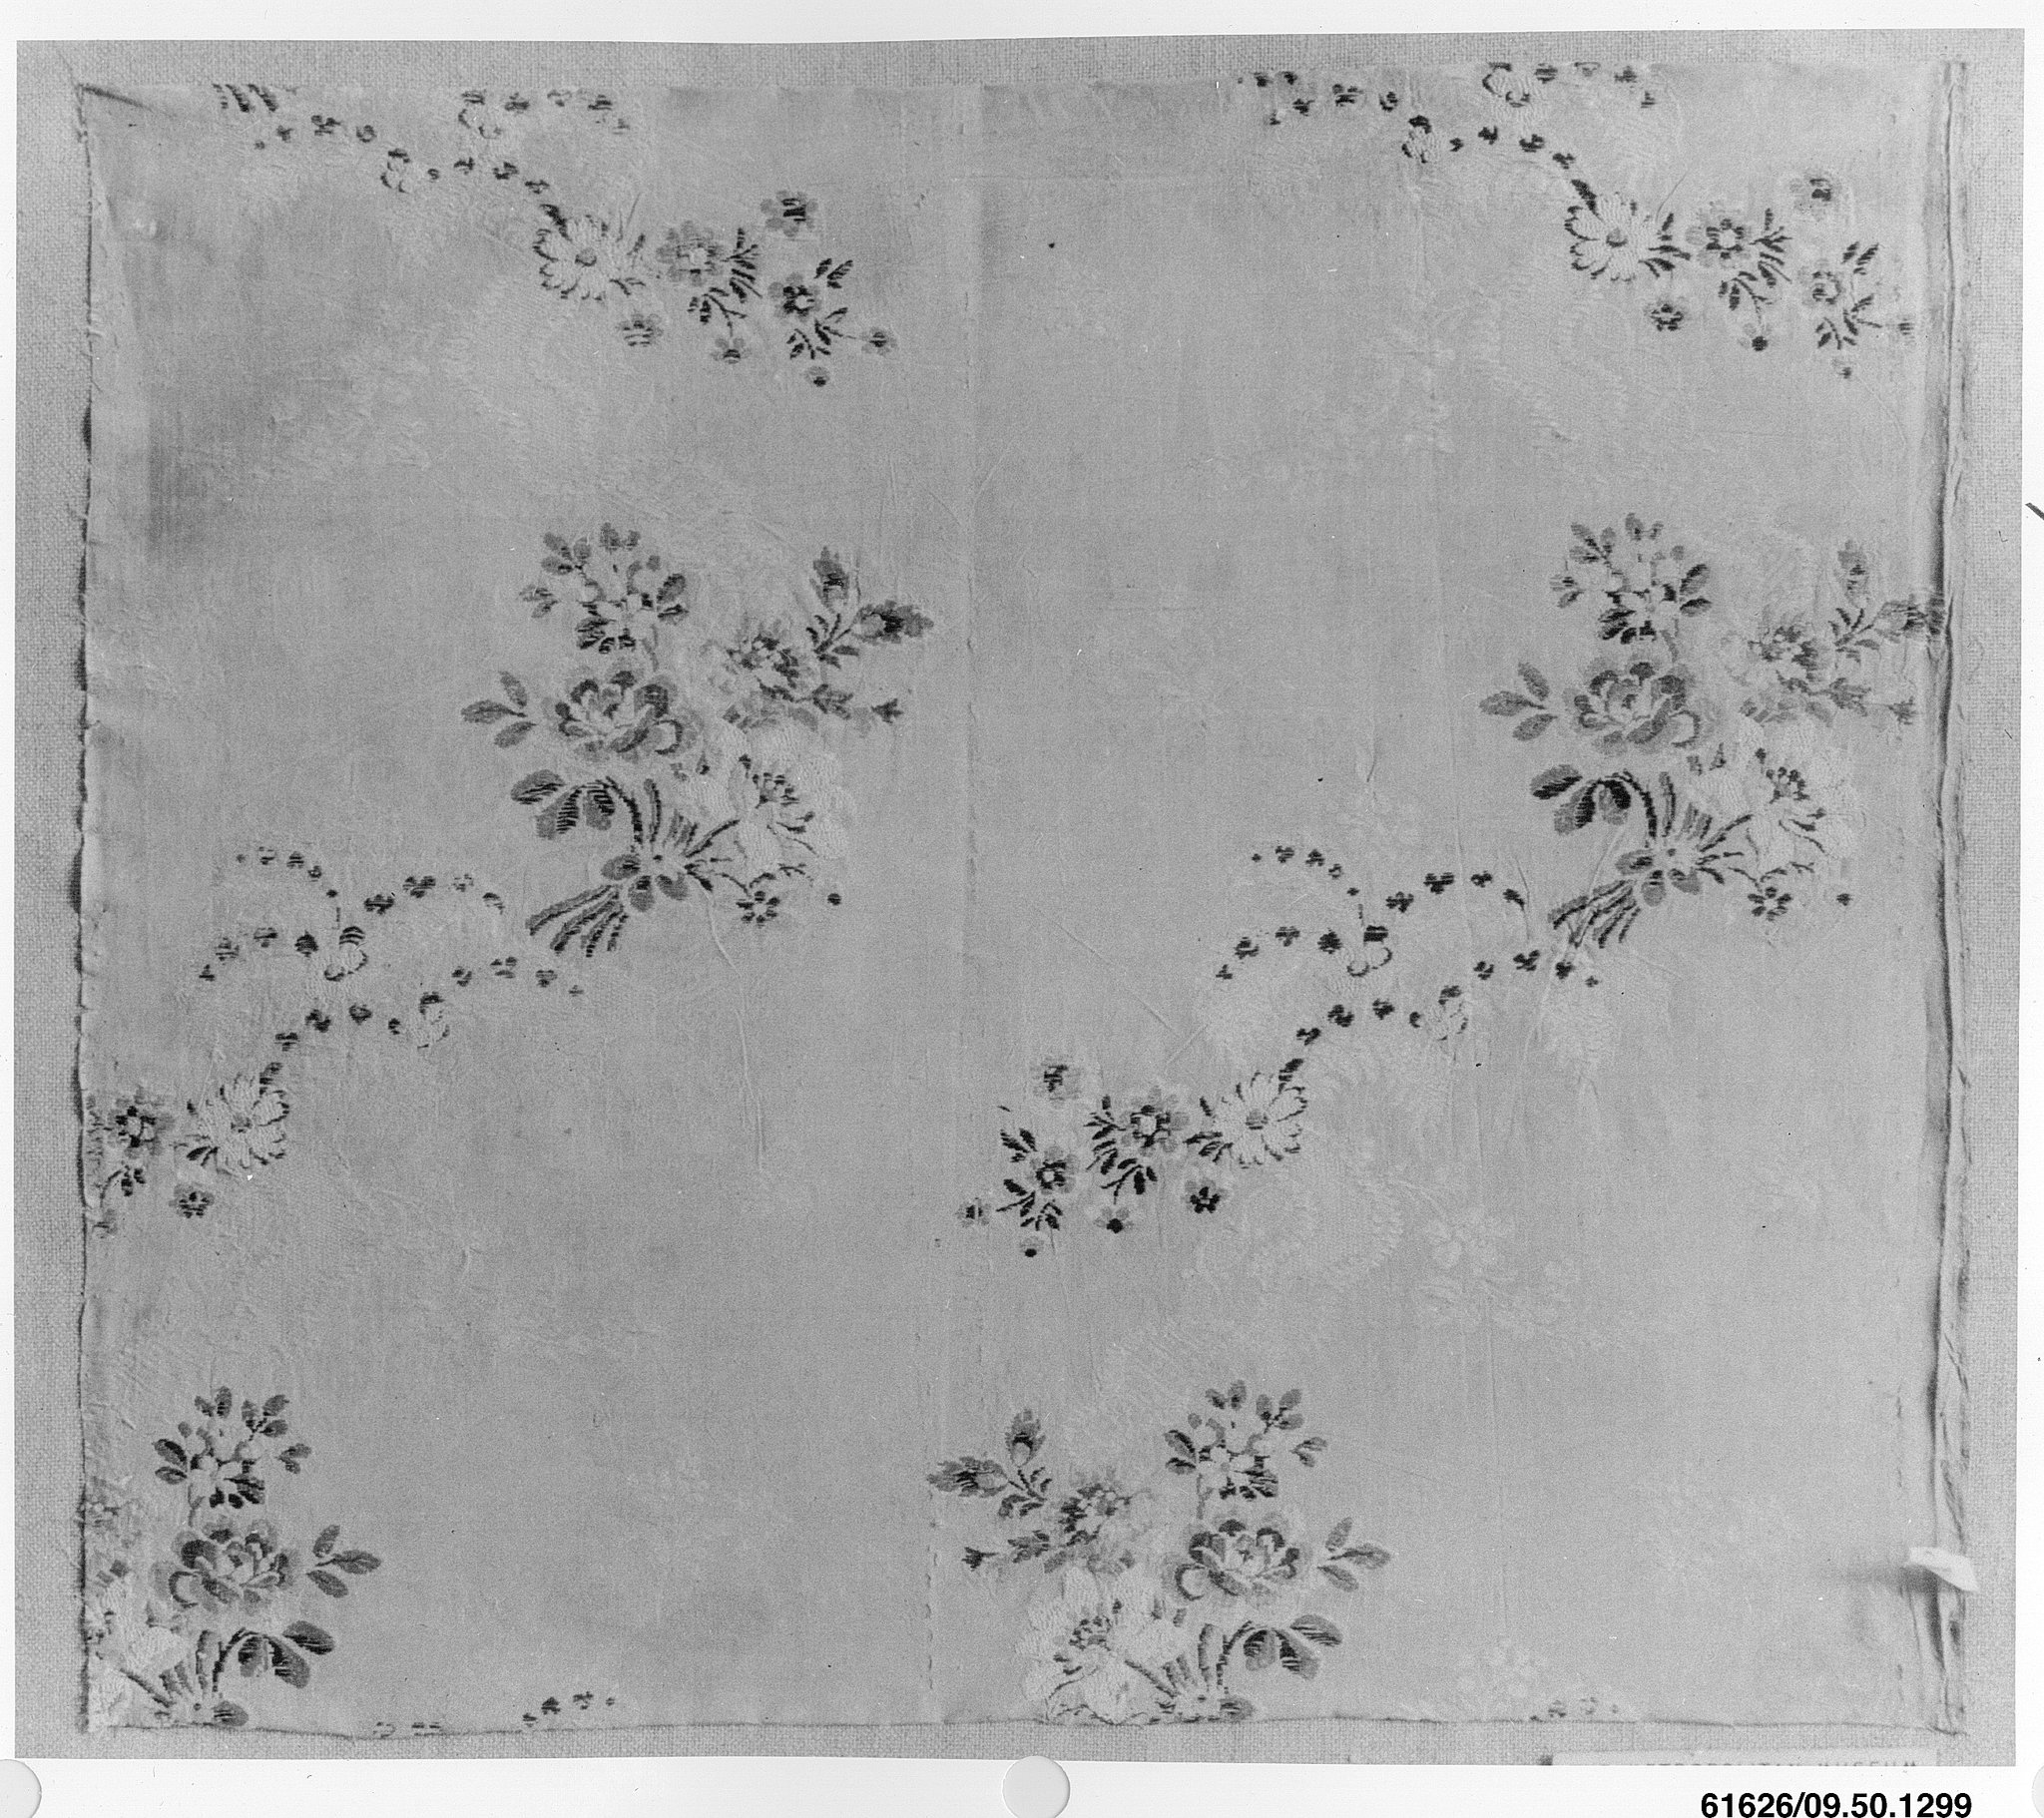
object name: piece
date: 1760-1770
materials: silk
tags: flowers,leaves